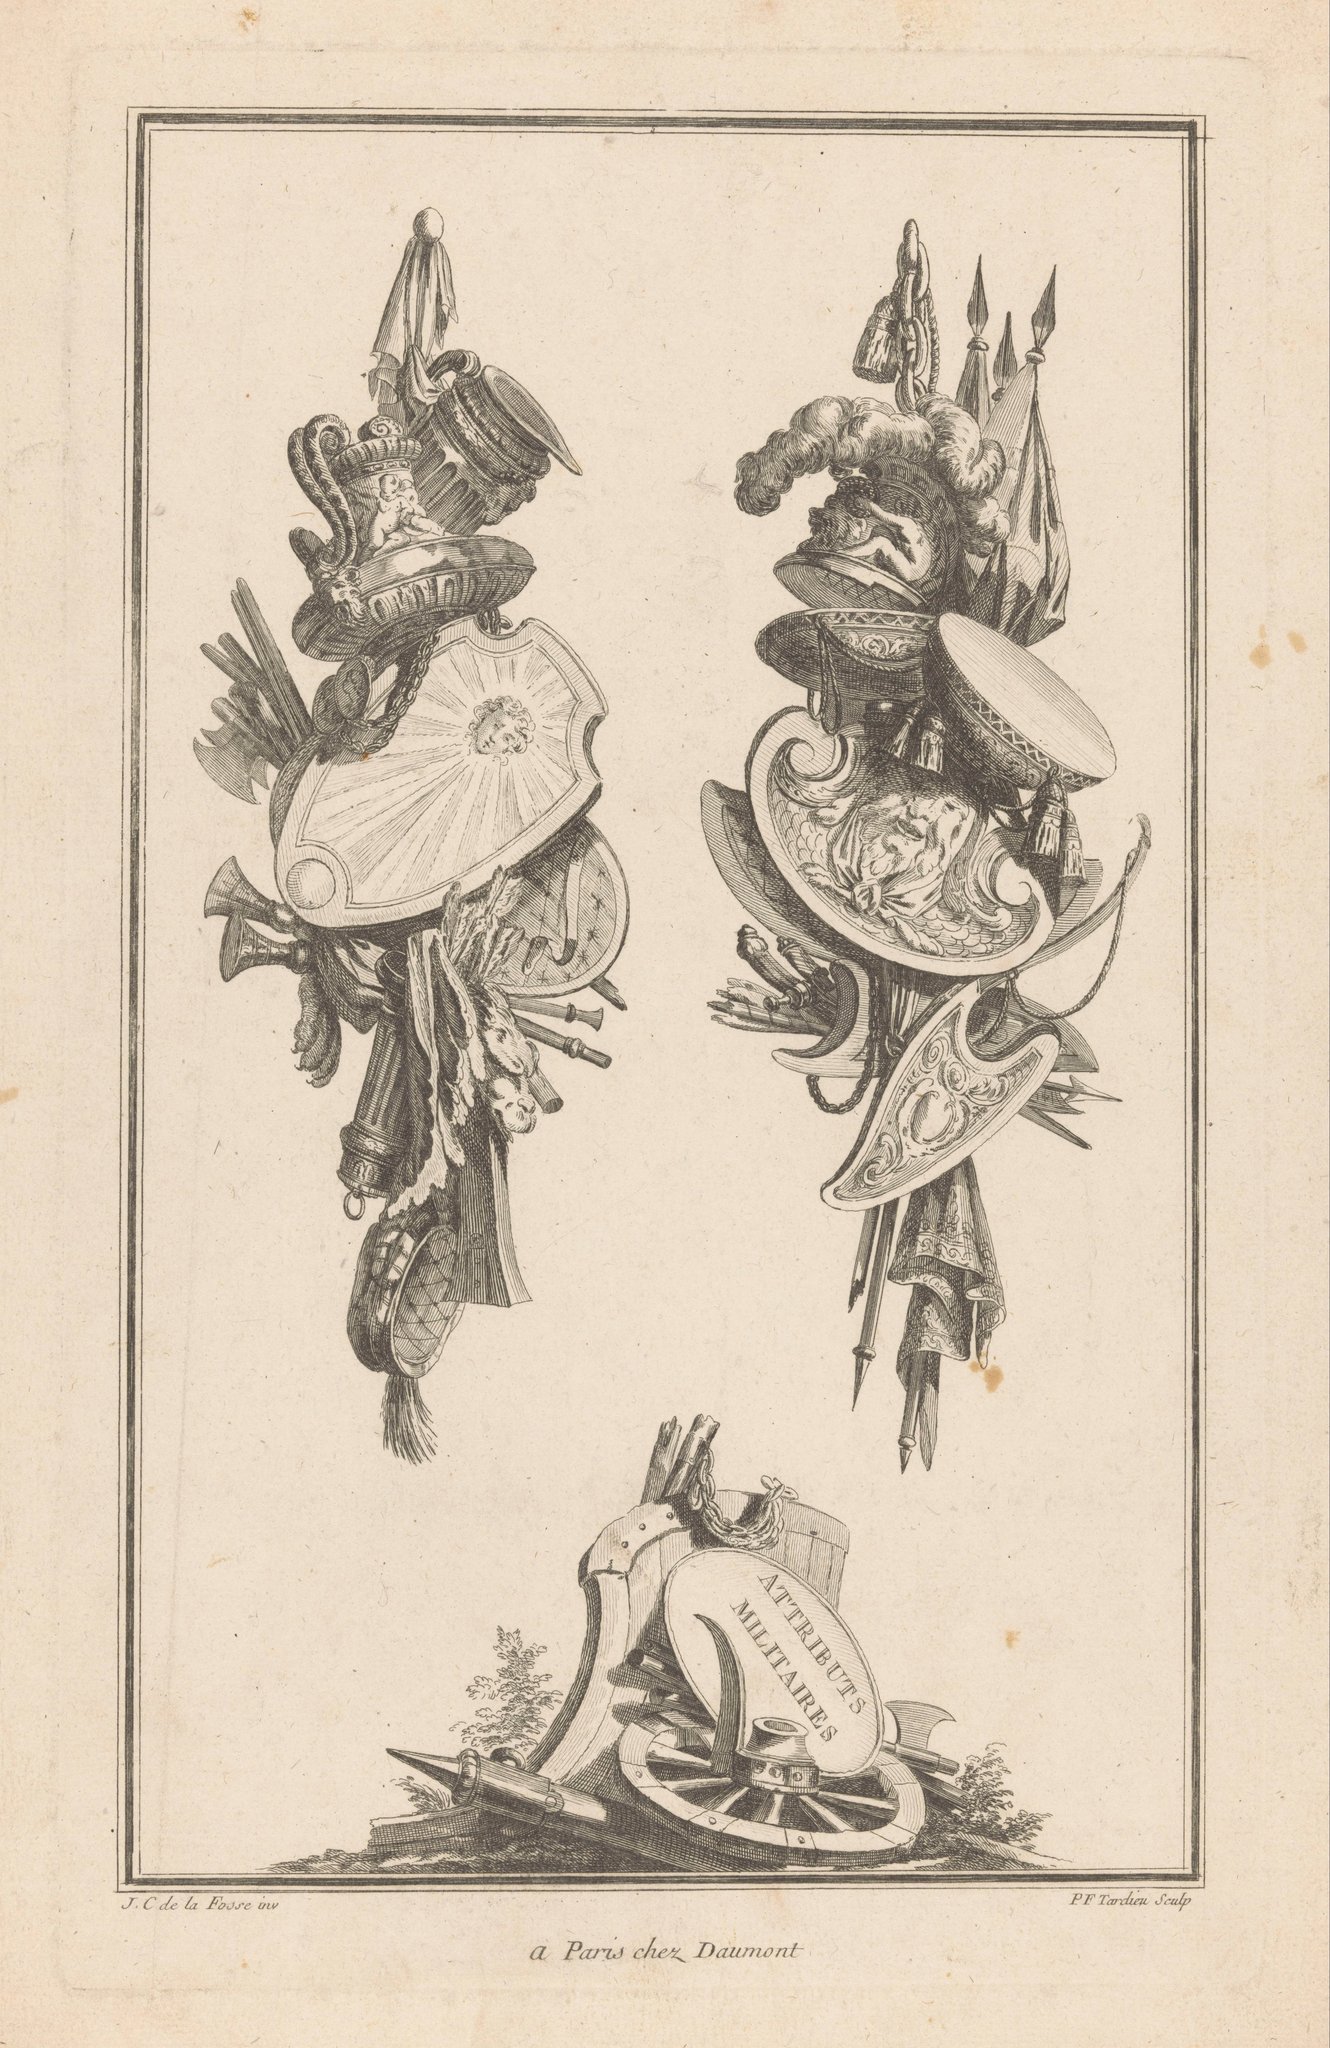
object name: ornament print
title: Trofeeën met schild en pluimenhelm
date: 1771-1775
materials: paper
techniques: engraving, etching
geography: paris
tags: trophy, i.e.: decorative arrangement of symbolic or typical objects ~ ornament, (military) equipment and supply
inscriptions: collector's mark: Lugt 2228, collector's mark: Lugt 2760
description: Links een trofee met vazen, wapens, een schild met de zon en dierenvellen. Rechts een trofee met vlaggen, een pluimenhelm, trommels en wapens.